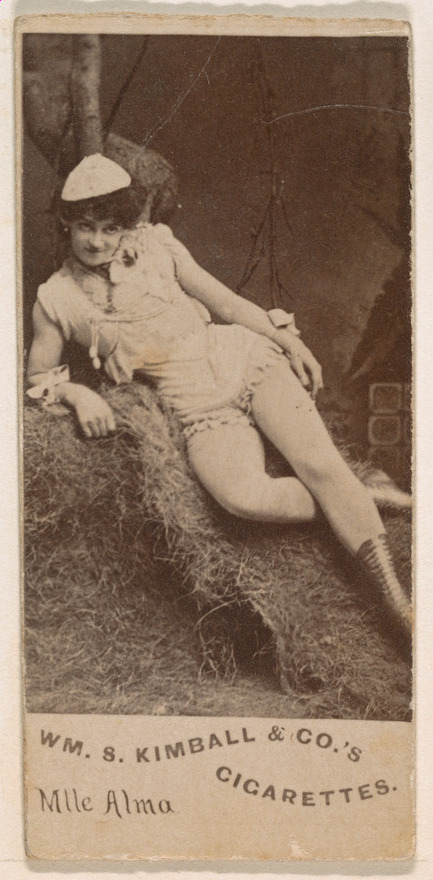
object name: photograph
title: Mlle. Alma, from the Actresses series (N203) issued by Wm. S. Kimball & Co.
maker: william s. kimball & company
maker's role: publisher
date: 1889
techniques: color lithograph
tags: portraits,women,actresses